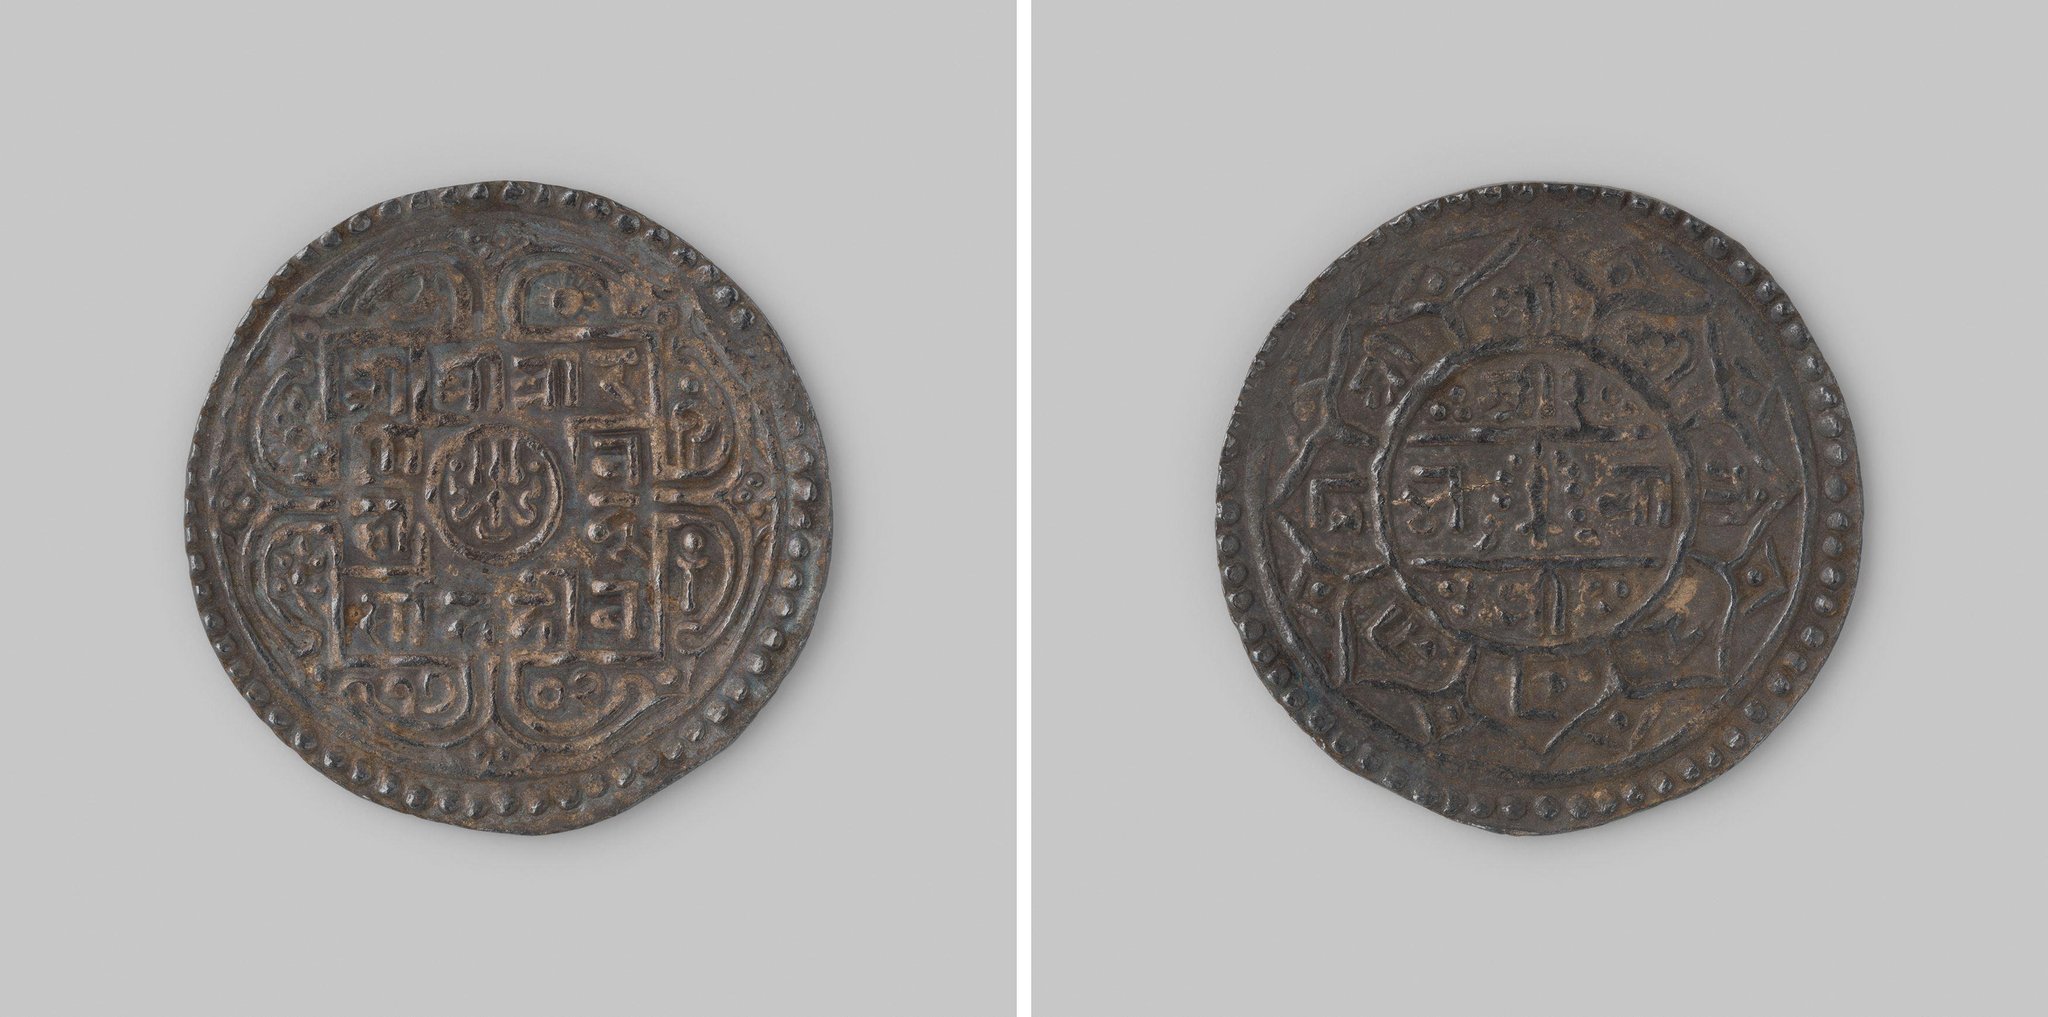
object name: coin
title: Mohar uit Nepal van Girvan Yuddha Vikrama uit de Gurkha dynastie, 1720 [= 1799]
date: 1799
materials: silver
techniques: striking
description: Zilveren munt. Voorzijde: binnen een vierkant in een cirkel een drietand, waaromheen twaalf tekens in Nagari-schrift met de betekenis: Girvan Yuddha Vikrama saha deva. Rondom het vierkant een soort van veelpas met ornamenten. In bovenste twee ornamenten drie dezelfde tekens in Nagari-schrift met de betekenis: sri, sri en nogmaals sri. In de onderste twee ornamenten jaartal in Nepalese cijfers: 1720. Keerzijde: binnen een cirkel een stupa. Rondom de cirkel een rand met ornamenten, waarin acht afgescheiden ruimtes, met in elke ruimte een teken in Nagari-schrift met de betekenis: sri sri sri Girvan Yuddha Vikrama saha deva [?]. Gladde rand.